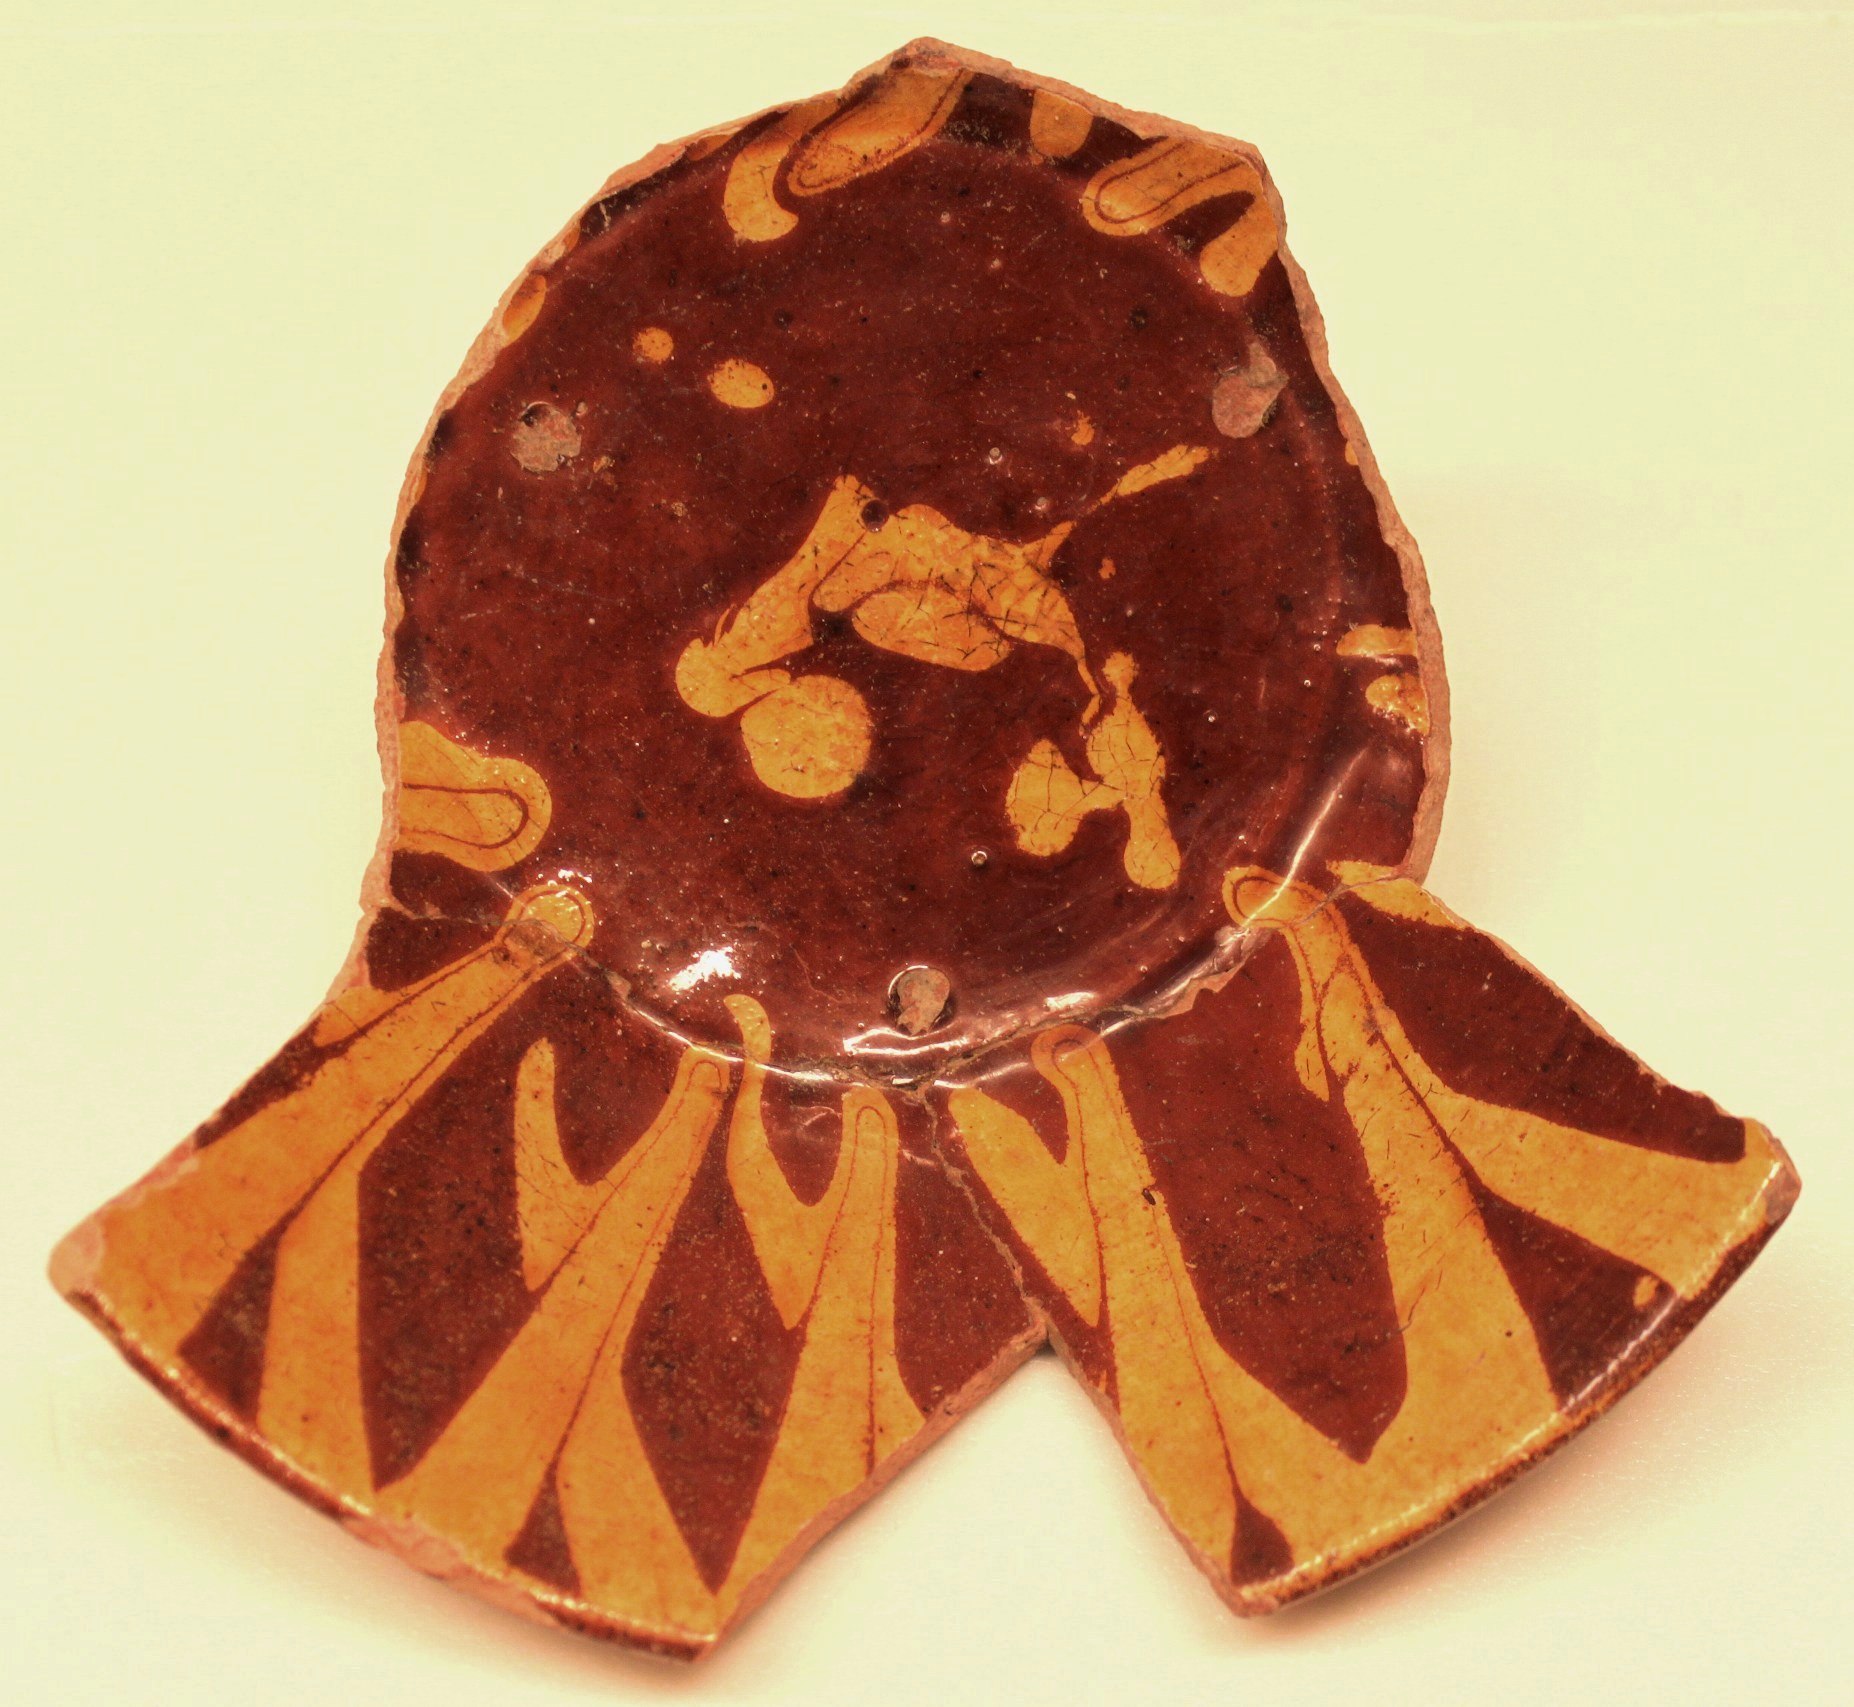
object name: fragment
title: Fragment of a Bowl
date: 1501-1700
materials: earthenware, glaze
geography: iran